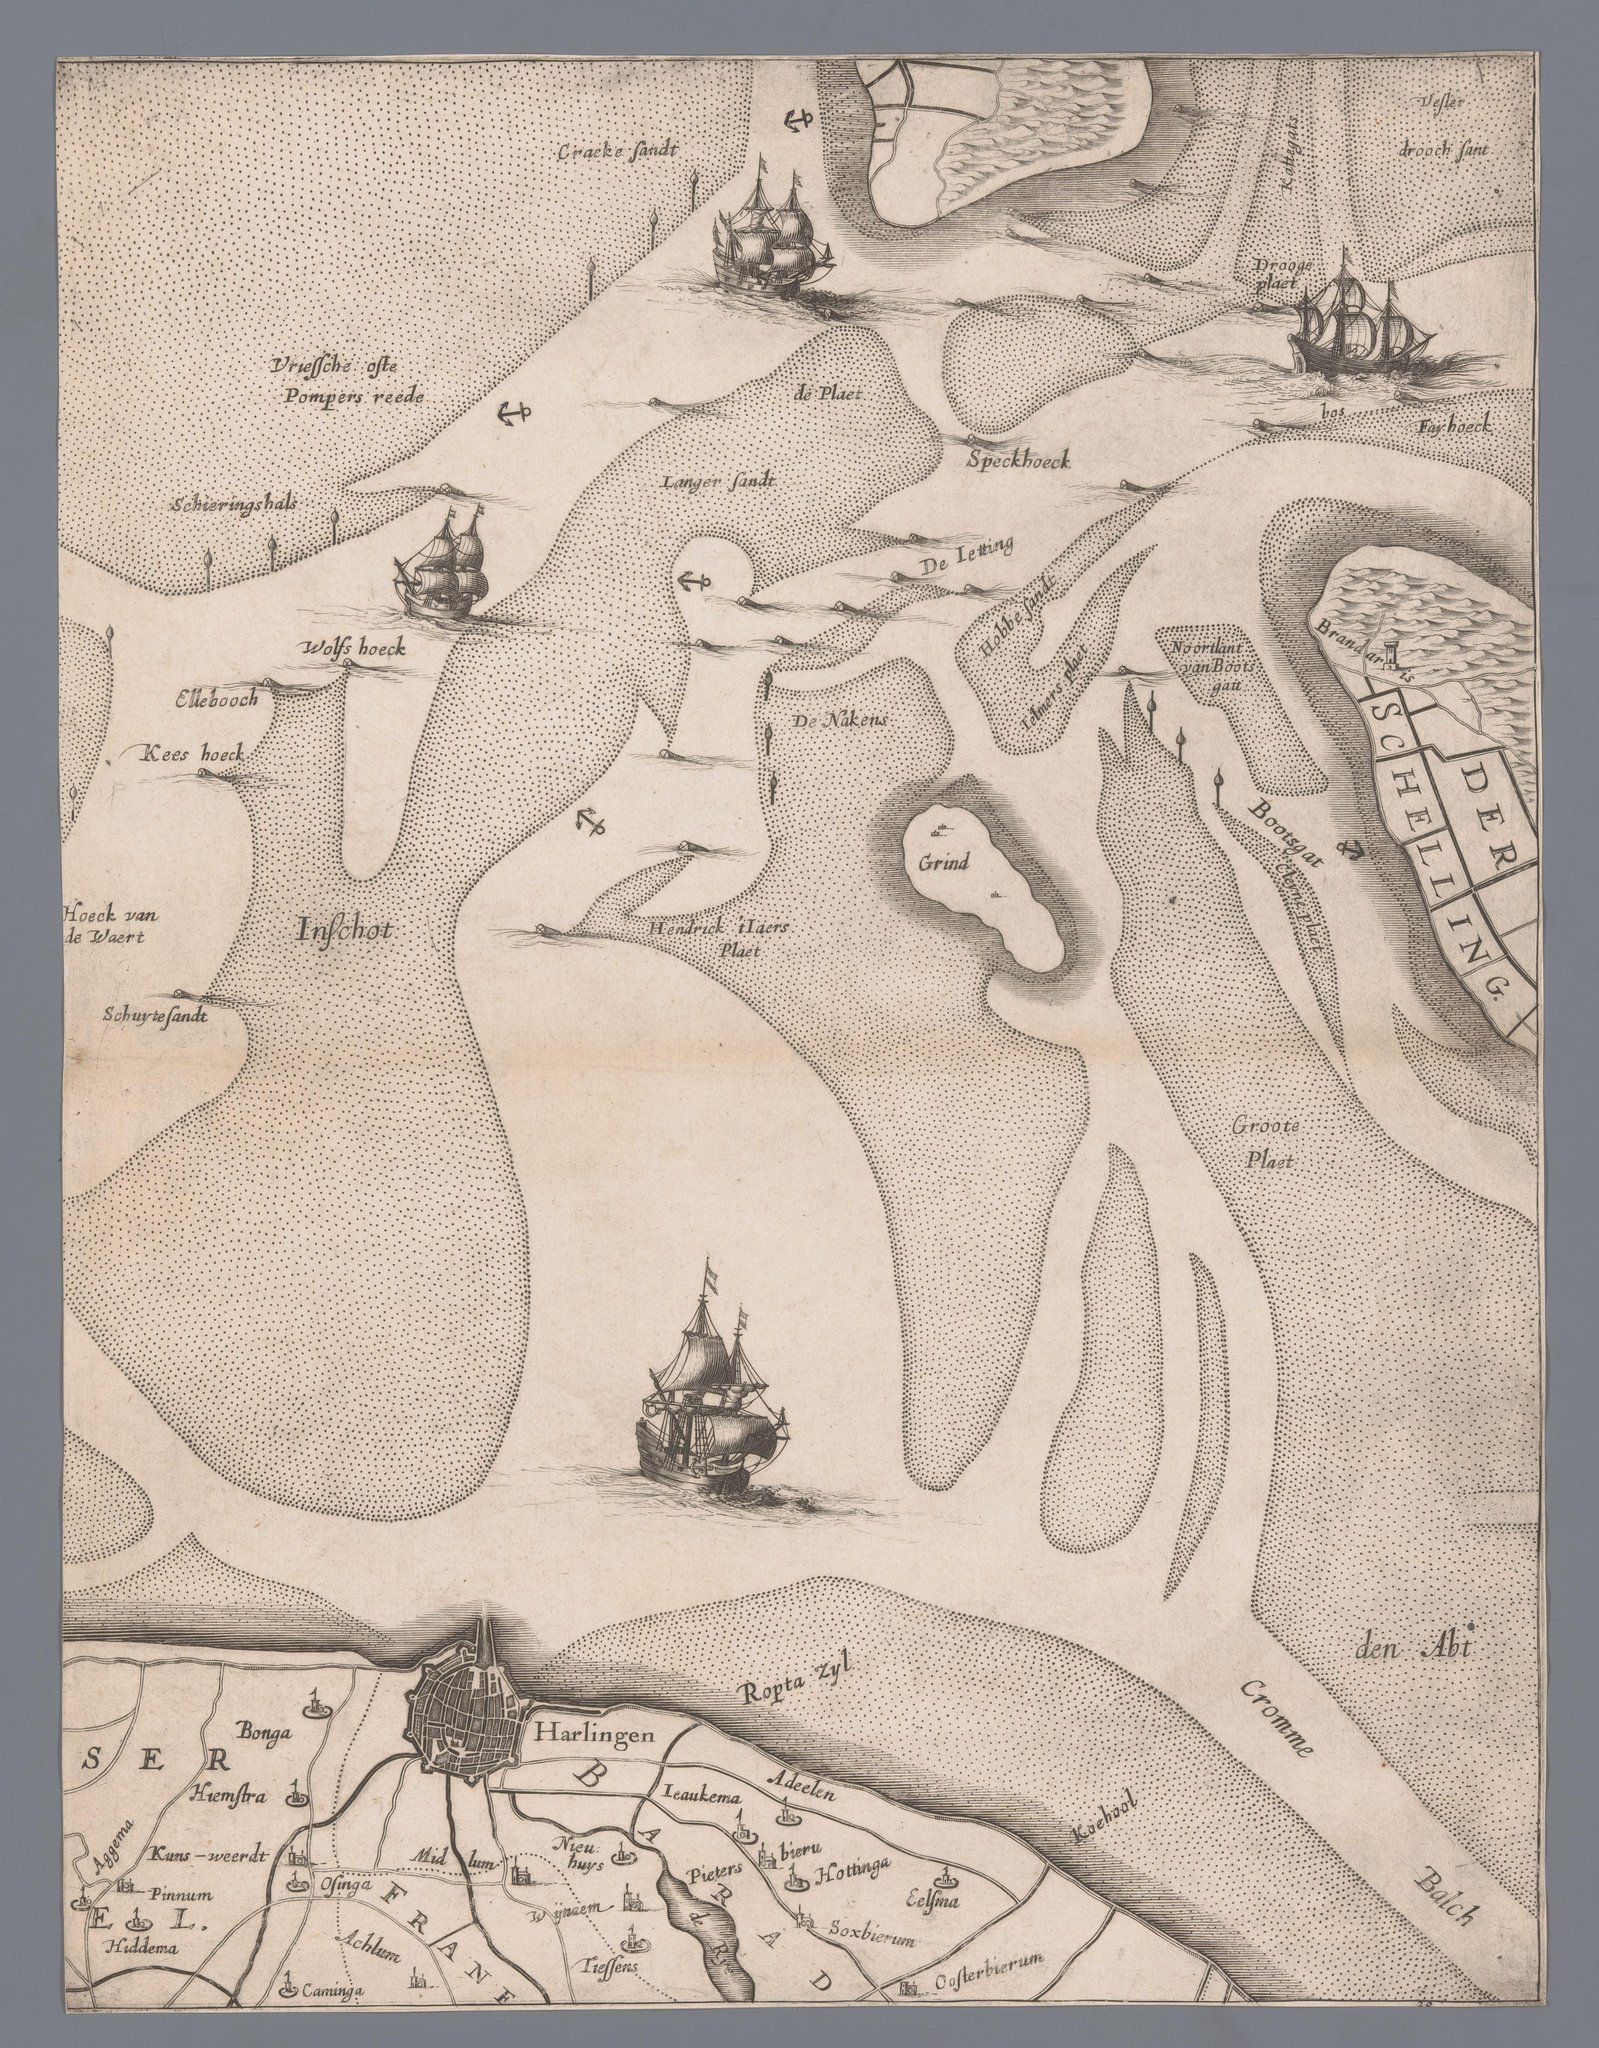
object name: map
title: Kaart van het Graafschap Holland en Utrecht (plaat 21)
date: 1639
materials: paper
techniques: engraving, etching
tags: sailing-ship, sailing-boat, maps, atlases, harlingen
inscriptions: collector's mark: Lugt 2228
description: Onderdeel van een kaart samengesteld uit 40 bladen. Waarschijnlijk gaat het om de grootste kaart van Holland uit de zeventiende-eeuw. De kaart is uitgegeven in verschillende edities, deze kaart uit 1639 is de eerste editie.